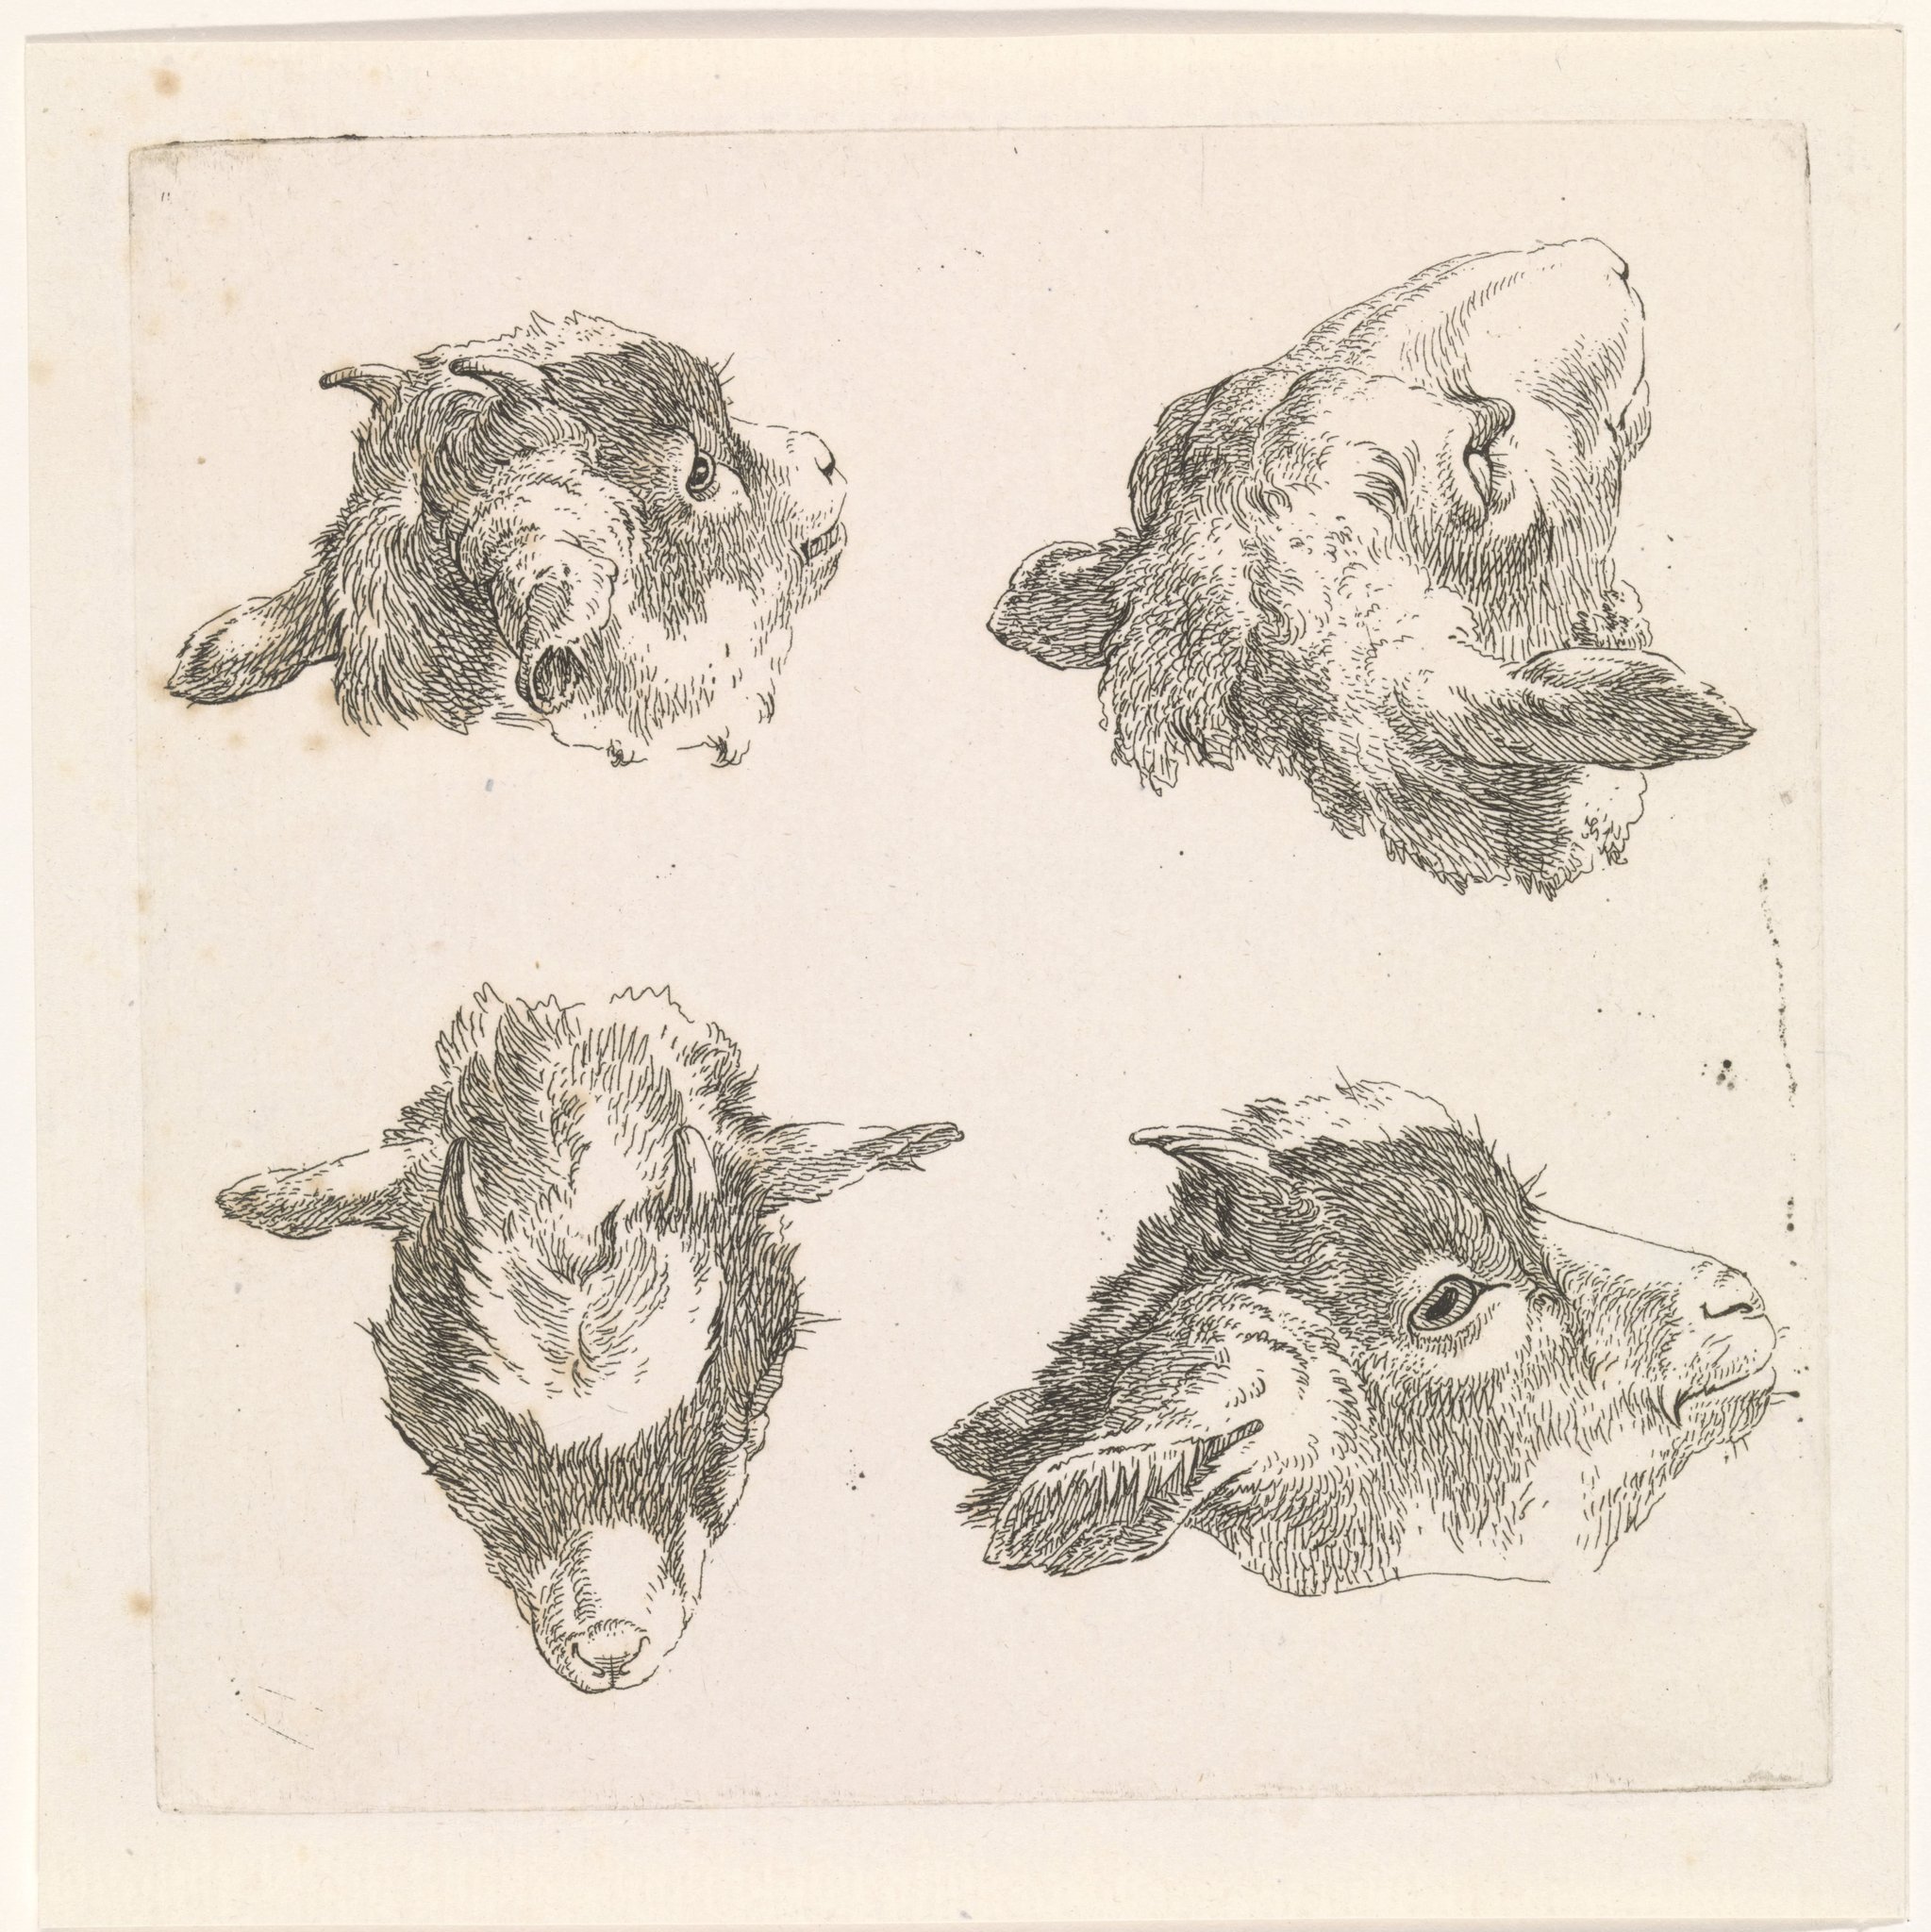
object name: print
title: Vier geitenkoppen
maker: barend hendrik thier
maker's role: draughtsman, print maker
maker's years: 1743-1811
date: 1755-1811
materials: paper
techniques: etching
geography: netherlands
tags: goat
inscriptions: collector's mark: Lugt 240